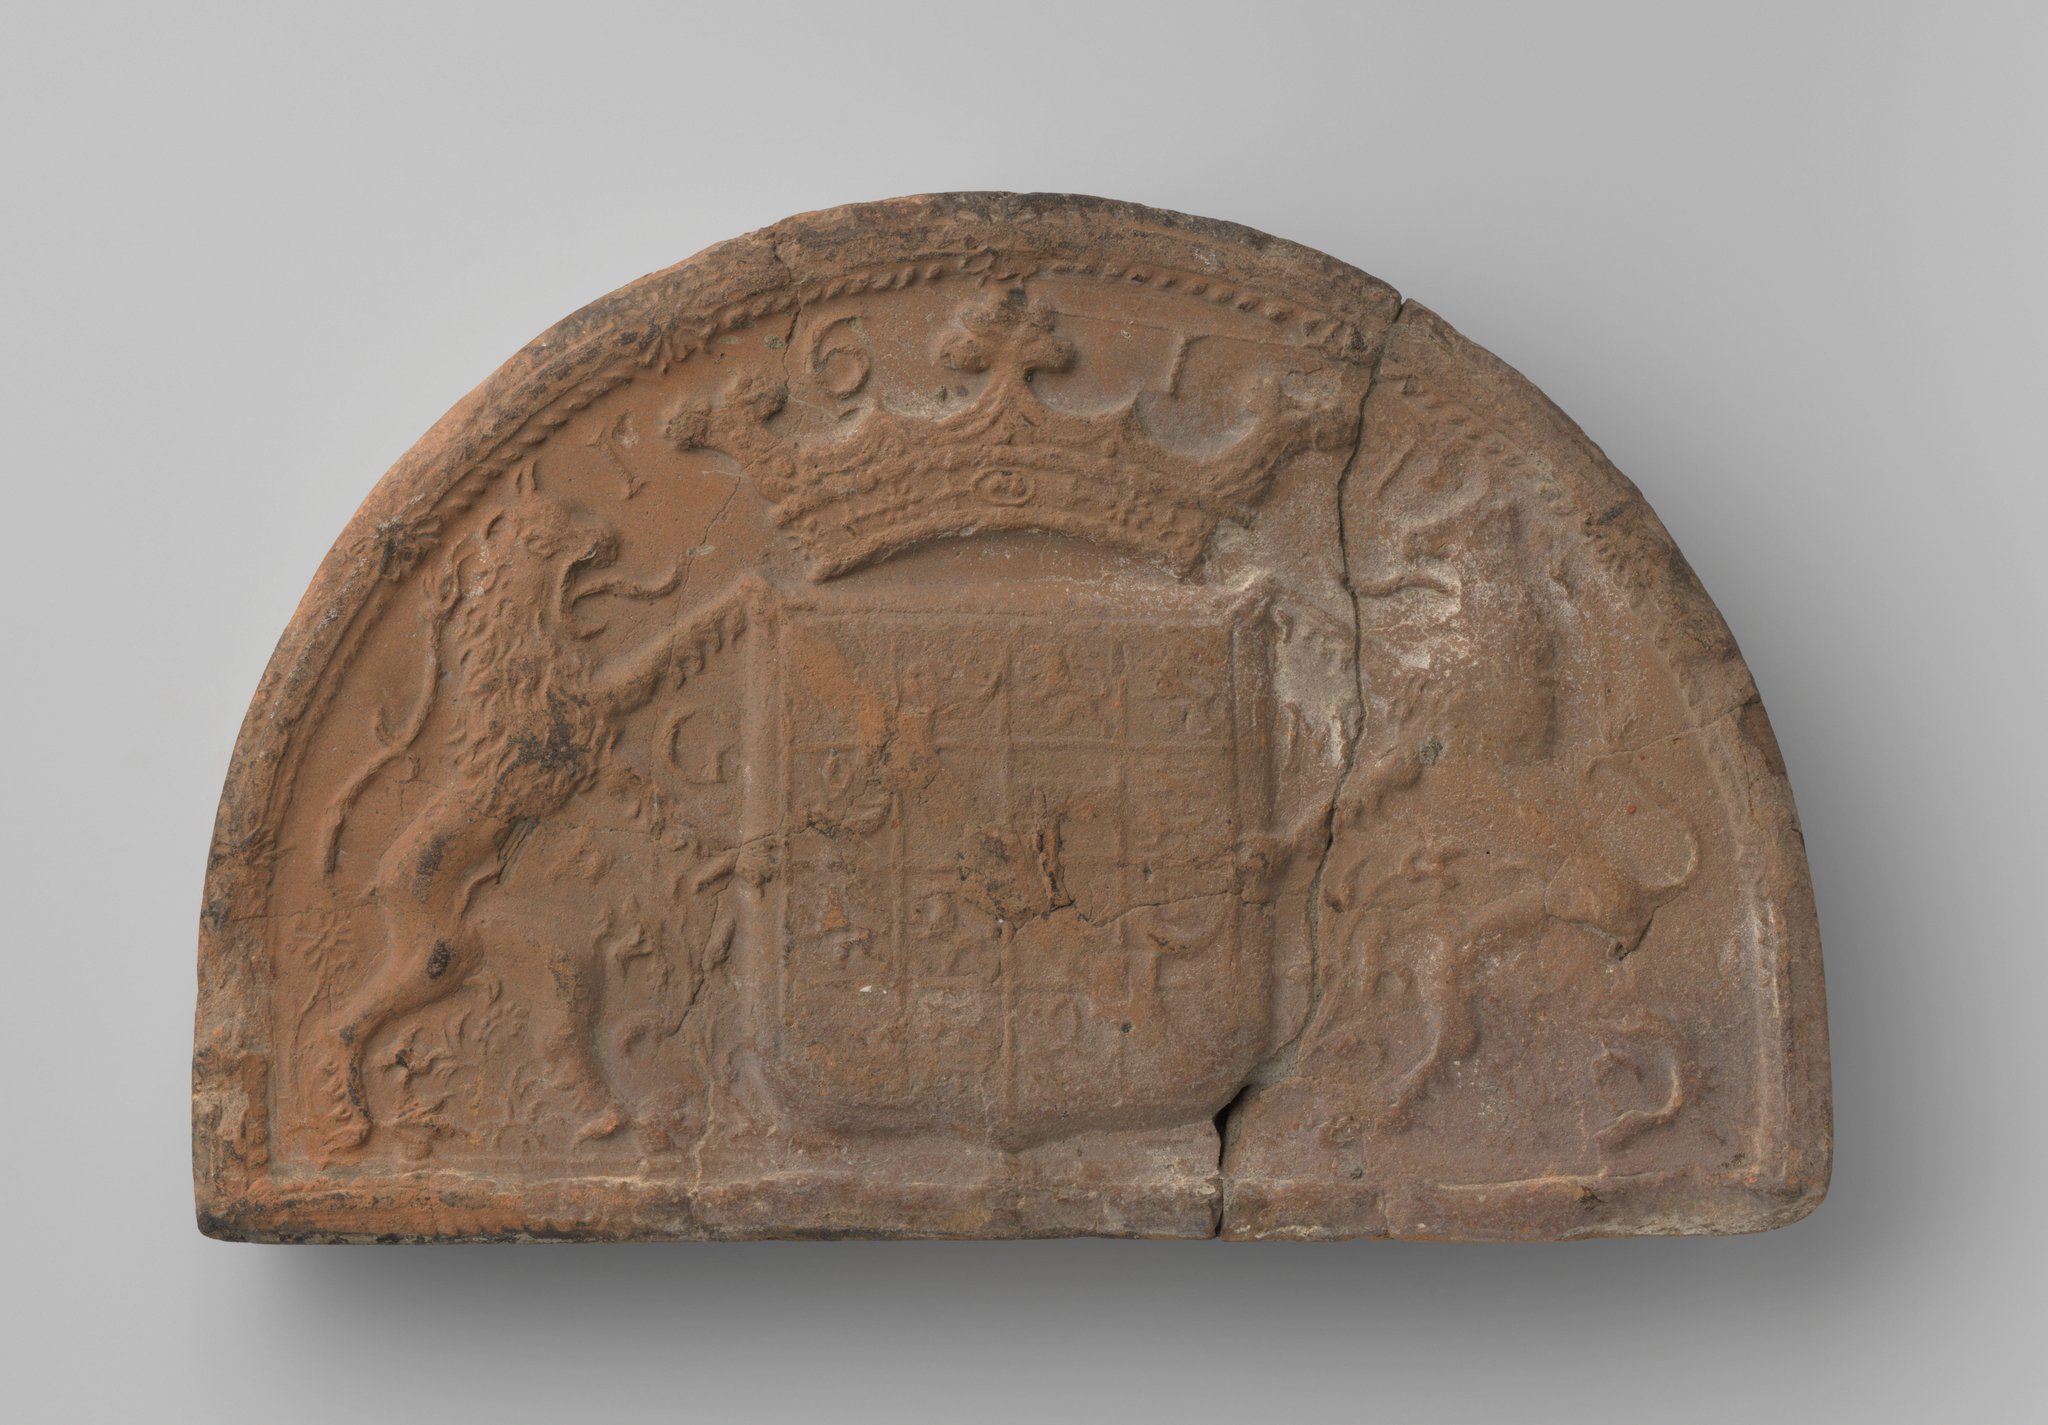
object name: haarddeksteen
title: Haarddeksteen met het wapen van Prins Maurits van Oranje Nassau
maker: Anonymous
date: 1611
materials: brick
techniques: printing, firing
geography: netherlands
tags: the hague, maurice (prince of orange)